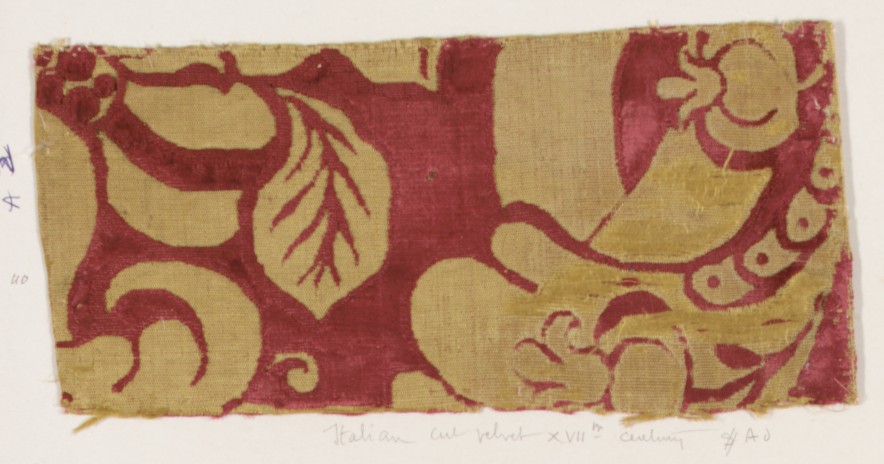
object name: fragment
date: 1601-1700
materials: metal thread, silk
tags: leaves